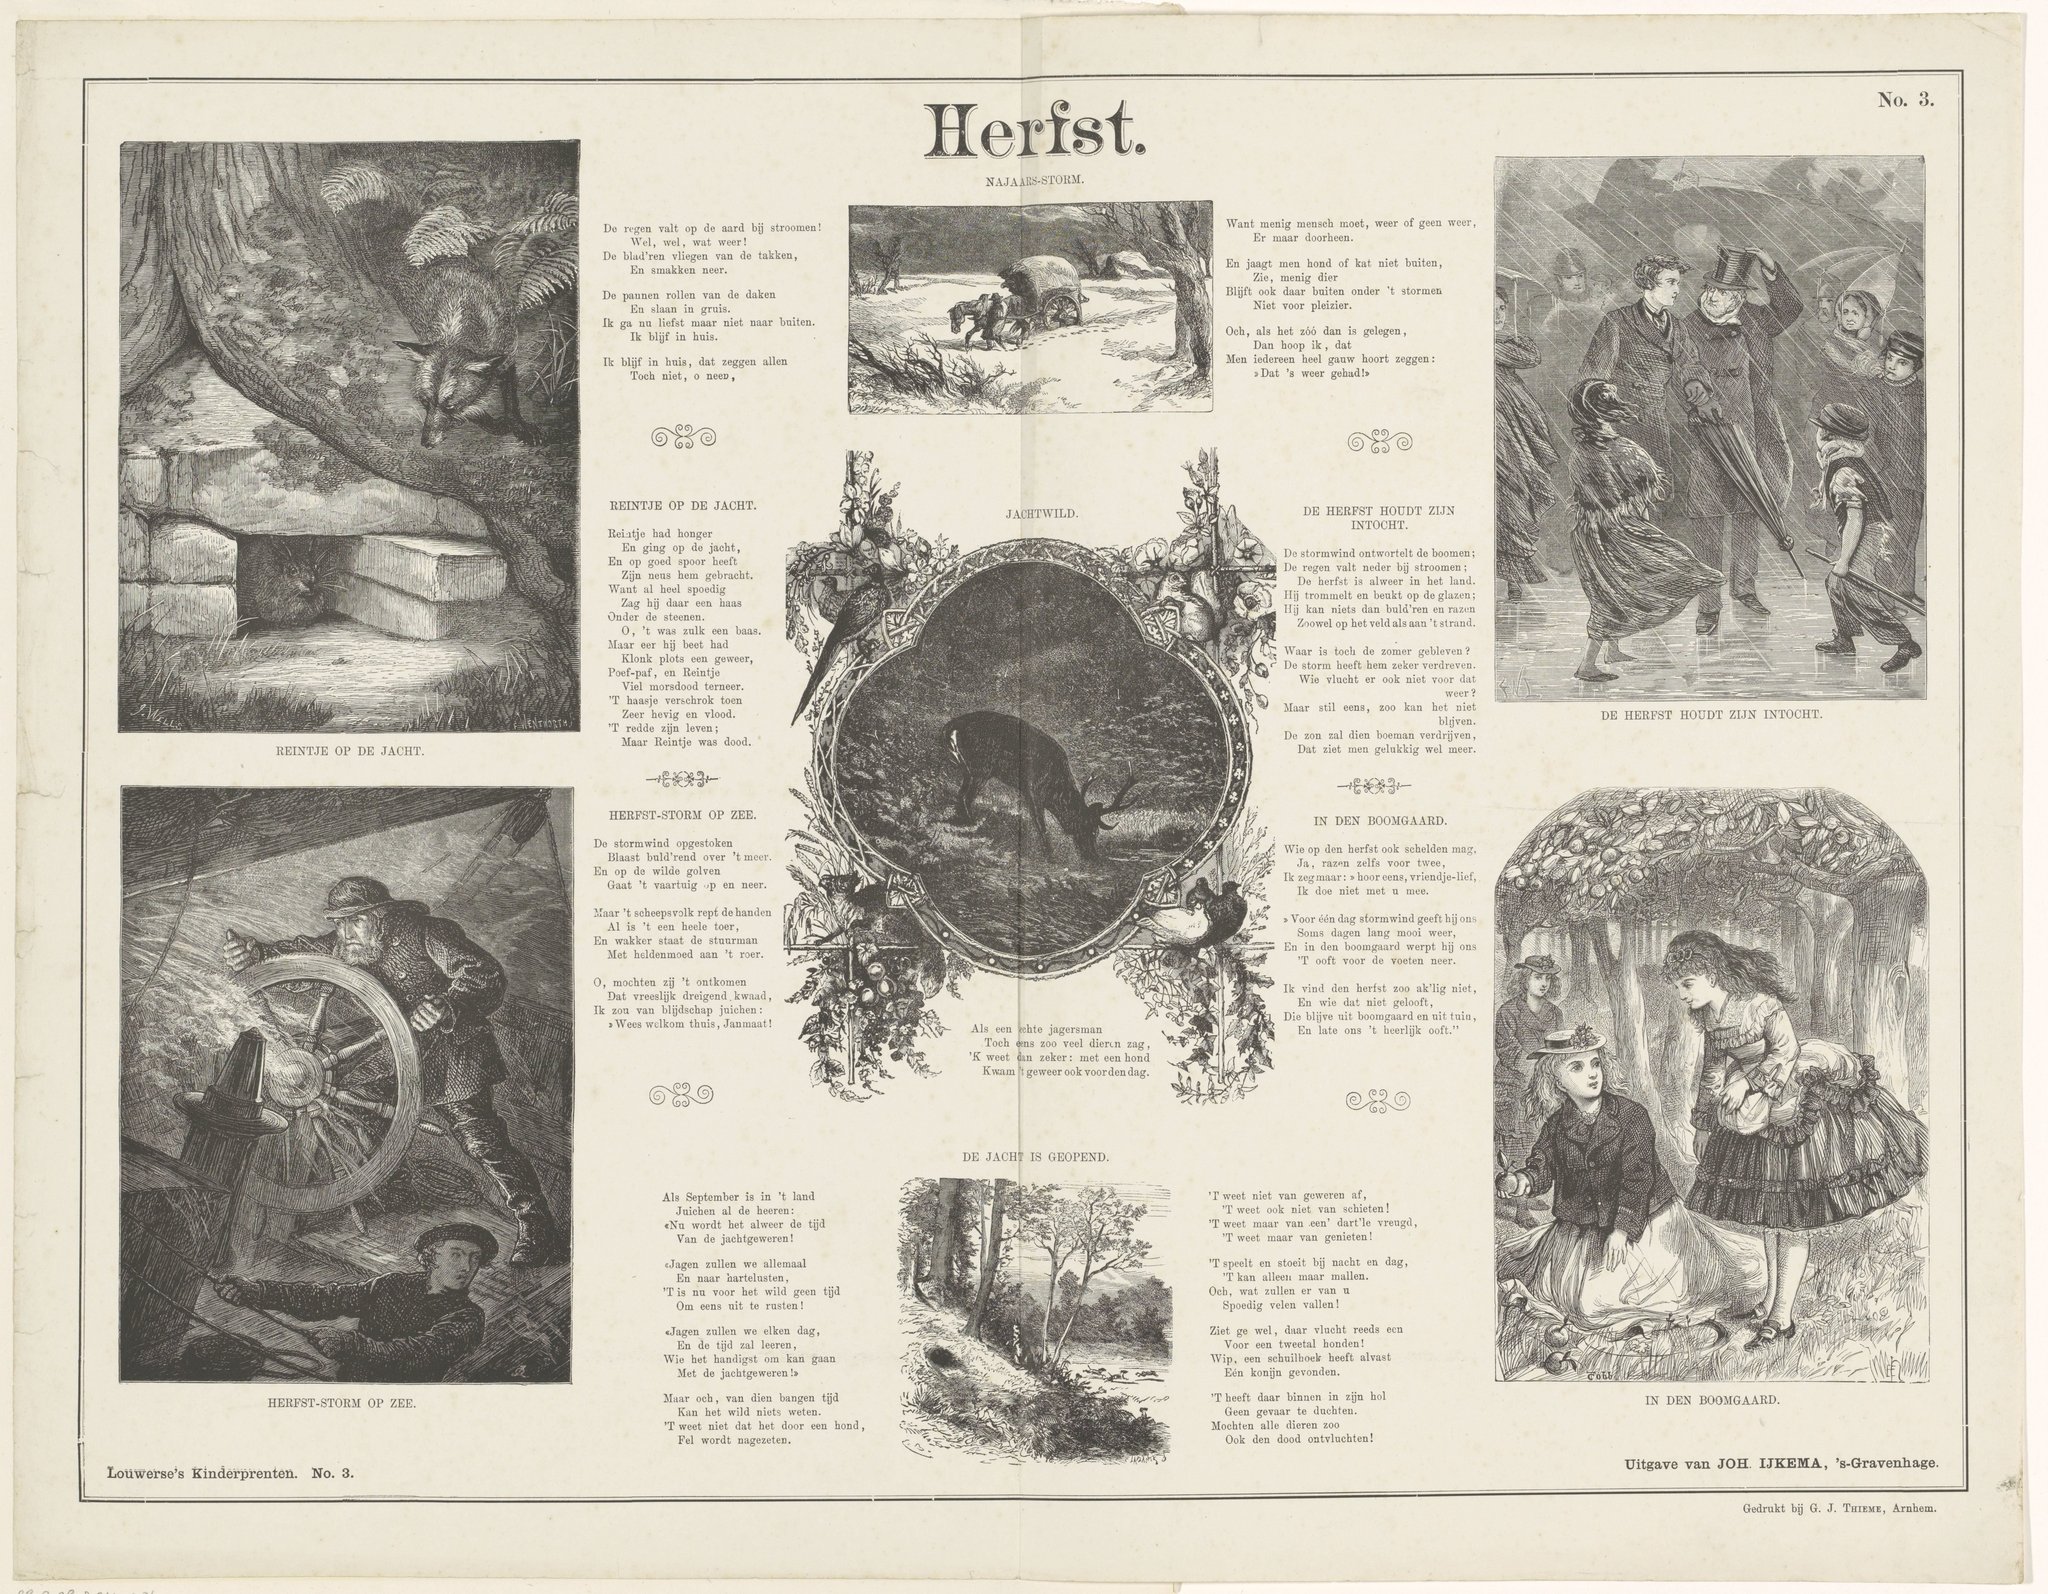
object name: print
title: Herfst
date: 1882-1905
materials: paper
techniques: letterpress printing, printing block, engraving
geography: arnhem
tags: autumn ~ other concepts (e.g. biblical scenes) (the four seasons of the year), rain, storm at sea, beasts of prey, predatory animals: fox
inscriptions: collector's mark: Lugt 2760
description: Blad met 7 voorstellingen van herfsttaferelen, zoals een vos op jacht, mensen in de regen en een herfststorm op zee. Tussen de afbeeldingen versjes in boekdruk. Genummerd rechtsboven en linksonder: No. 3.